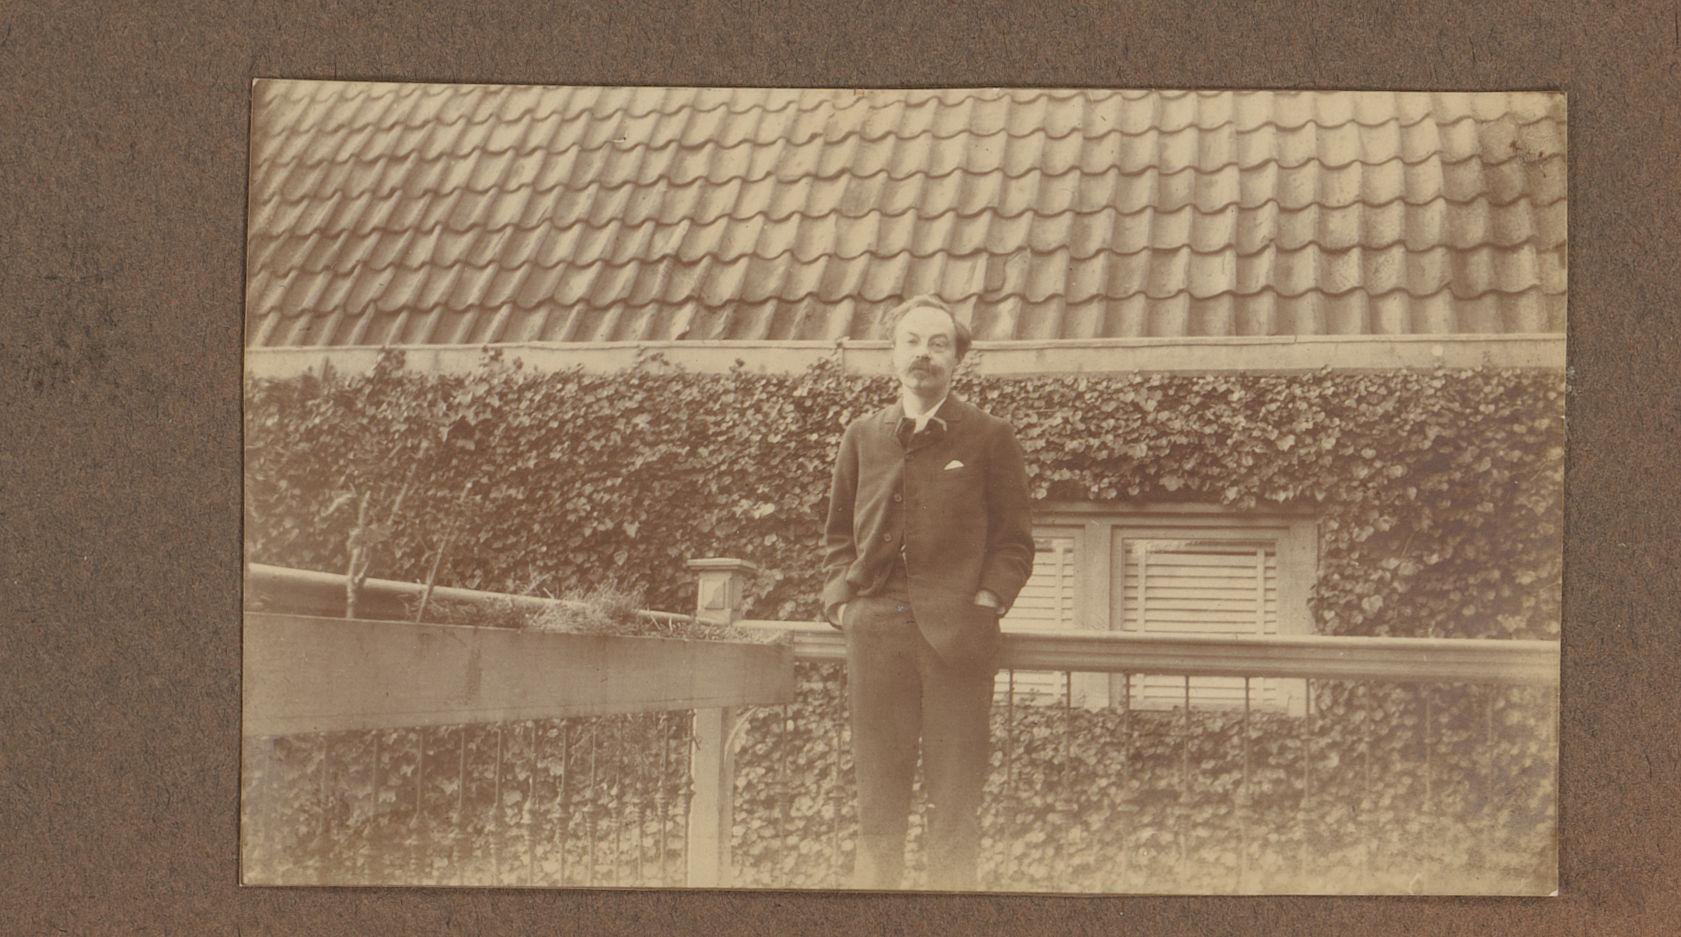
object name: photograph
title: Alphons Diepenbrock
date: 1908-1915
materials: photographic support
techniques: photography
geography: amsterdam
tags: alphons diepenbrock, netherlands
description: Foto op bruin albumblad 47 van familiealbum van Alphons Diepenbrock.